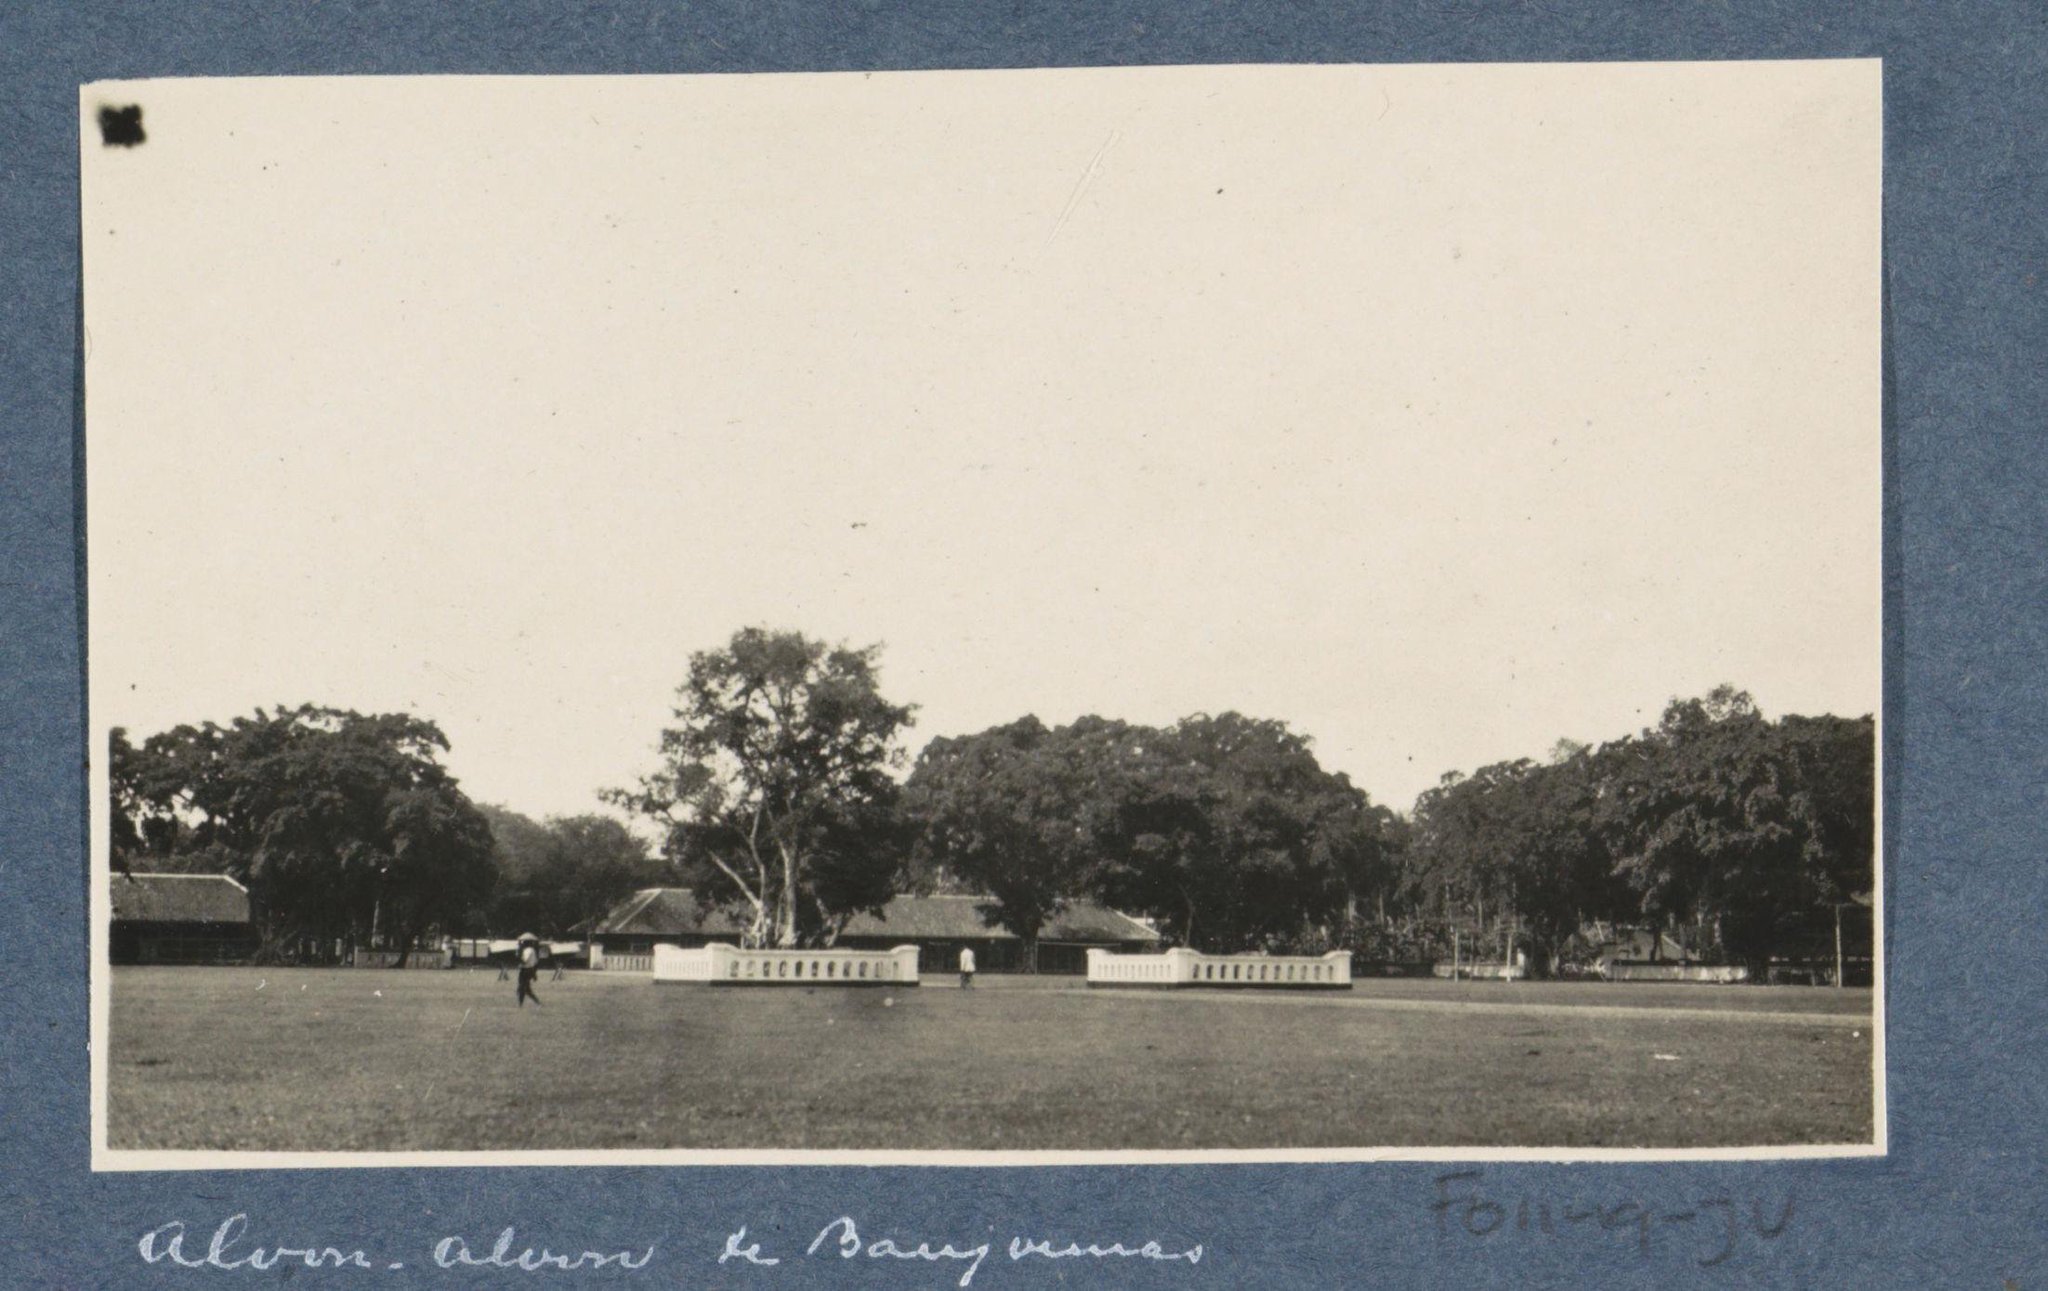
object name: photograph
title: Gezicht op de Serayu bij Banjoemas op Java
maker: Anonymous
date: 1900-1920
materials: paper, photographic support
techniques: gelatin silver print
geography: java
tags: river (+ landscape with figures, staffage), java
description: Onderdeel van reisalbum met foto's van bedrijvigheid en bezienswaardigheden op Sumatra en Java en van de reis naar en van Nederlands-Indië.